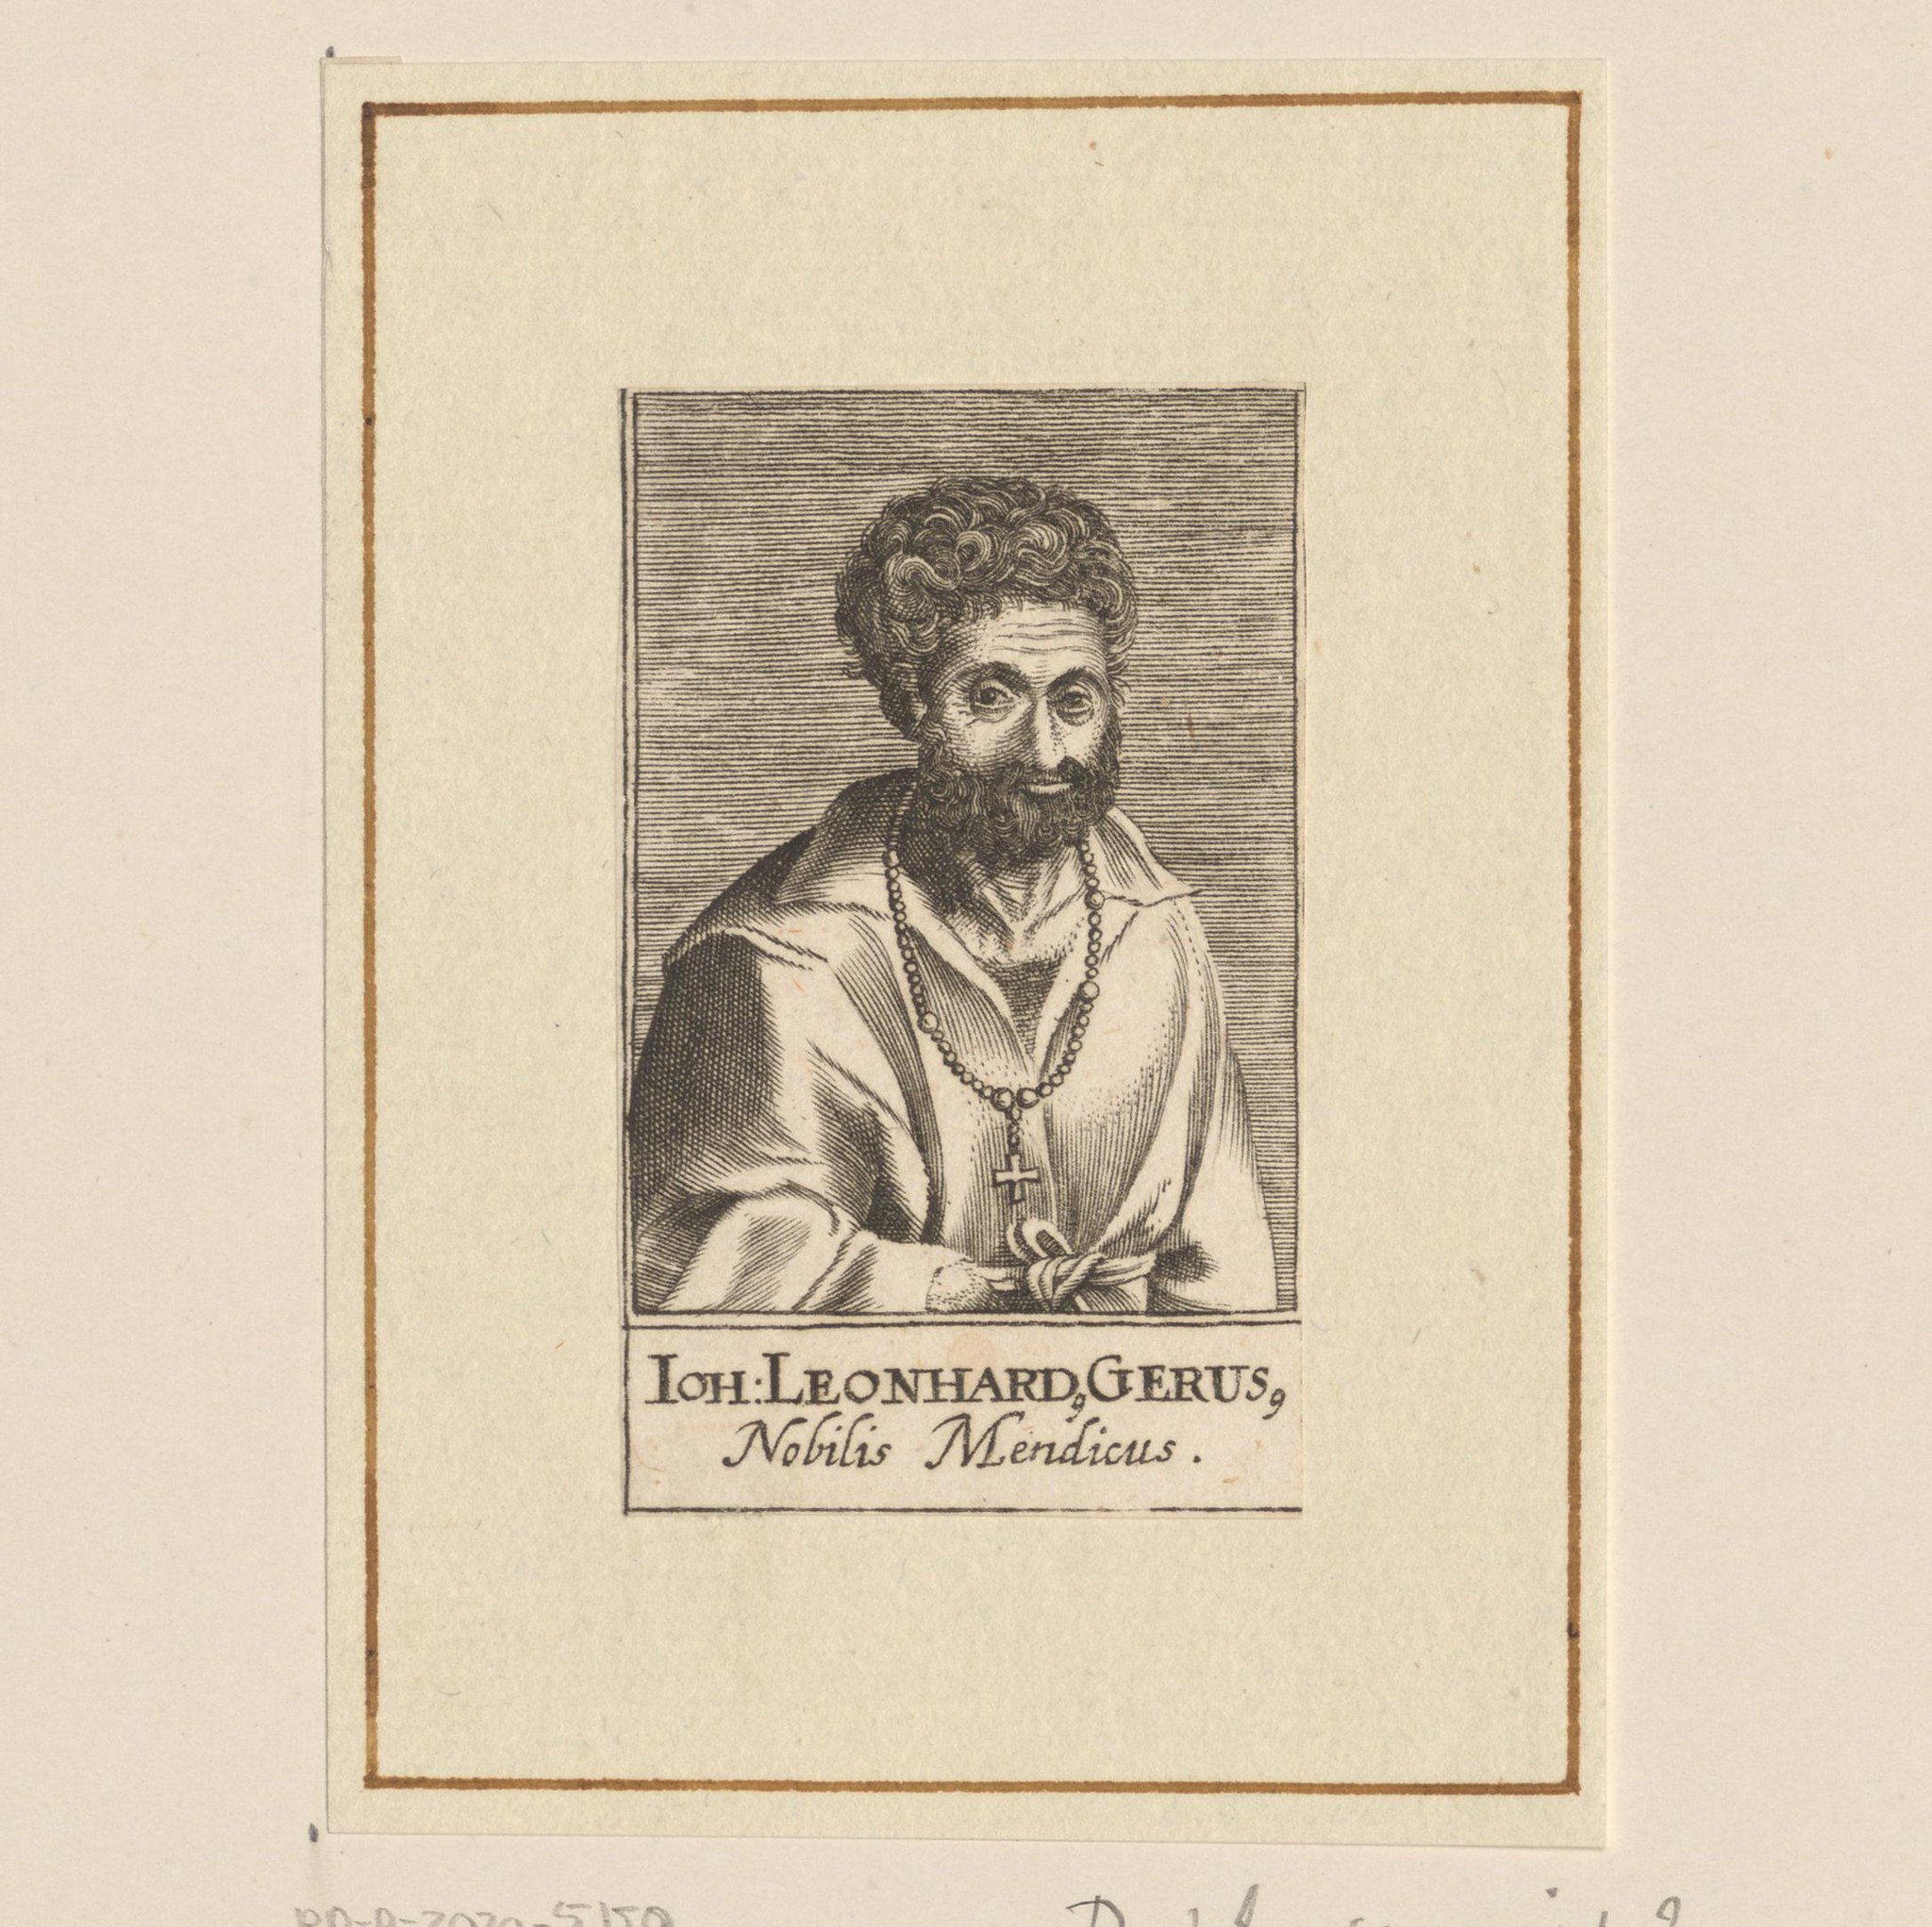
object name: print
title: Portret van Giovanni Leonardo Geruso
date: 1688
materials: paper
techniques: engraving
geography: nuremberg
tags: theologian, historical persons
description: Prent uit: Freher, Paul. Theatrum virorum eruditione clarorum. Neurenberg: Johann Hoffmann, 1688.